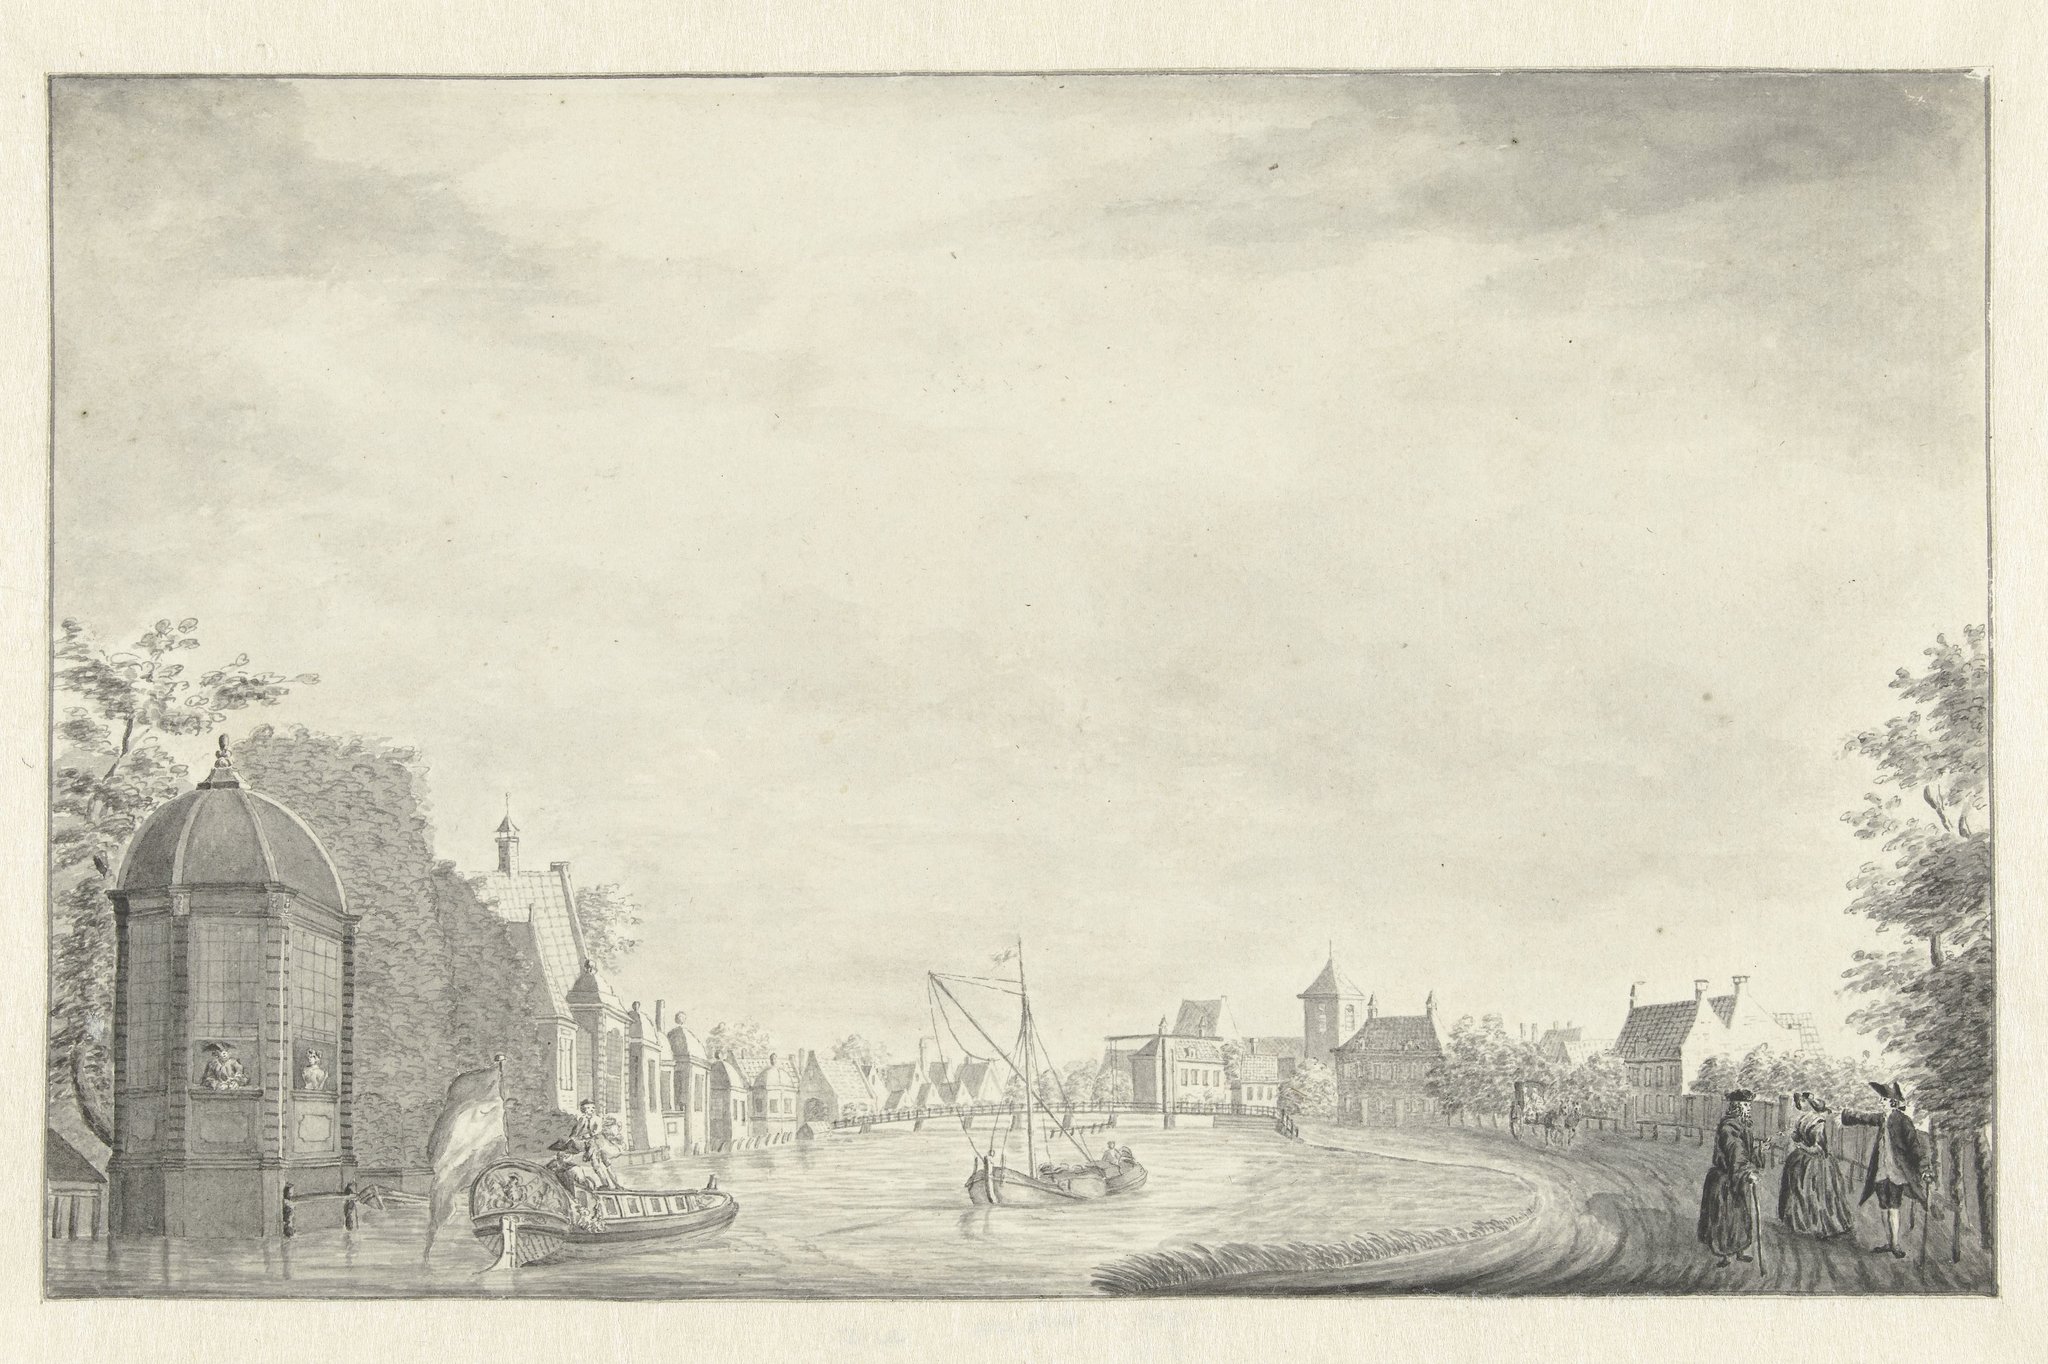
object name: drawing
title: Ouderkerk aan de Amstel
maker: jan de beijer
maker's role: draughtsman, print maker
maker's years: 1703-1780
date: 1756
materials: ink, paper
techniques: brush, pen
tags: prospect of city, town panorama, silhouette of city